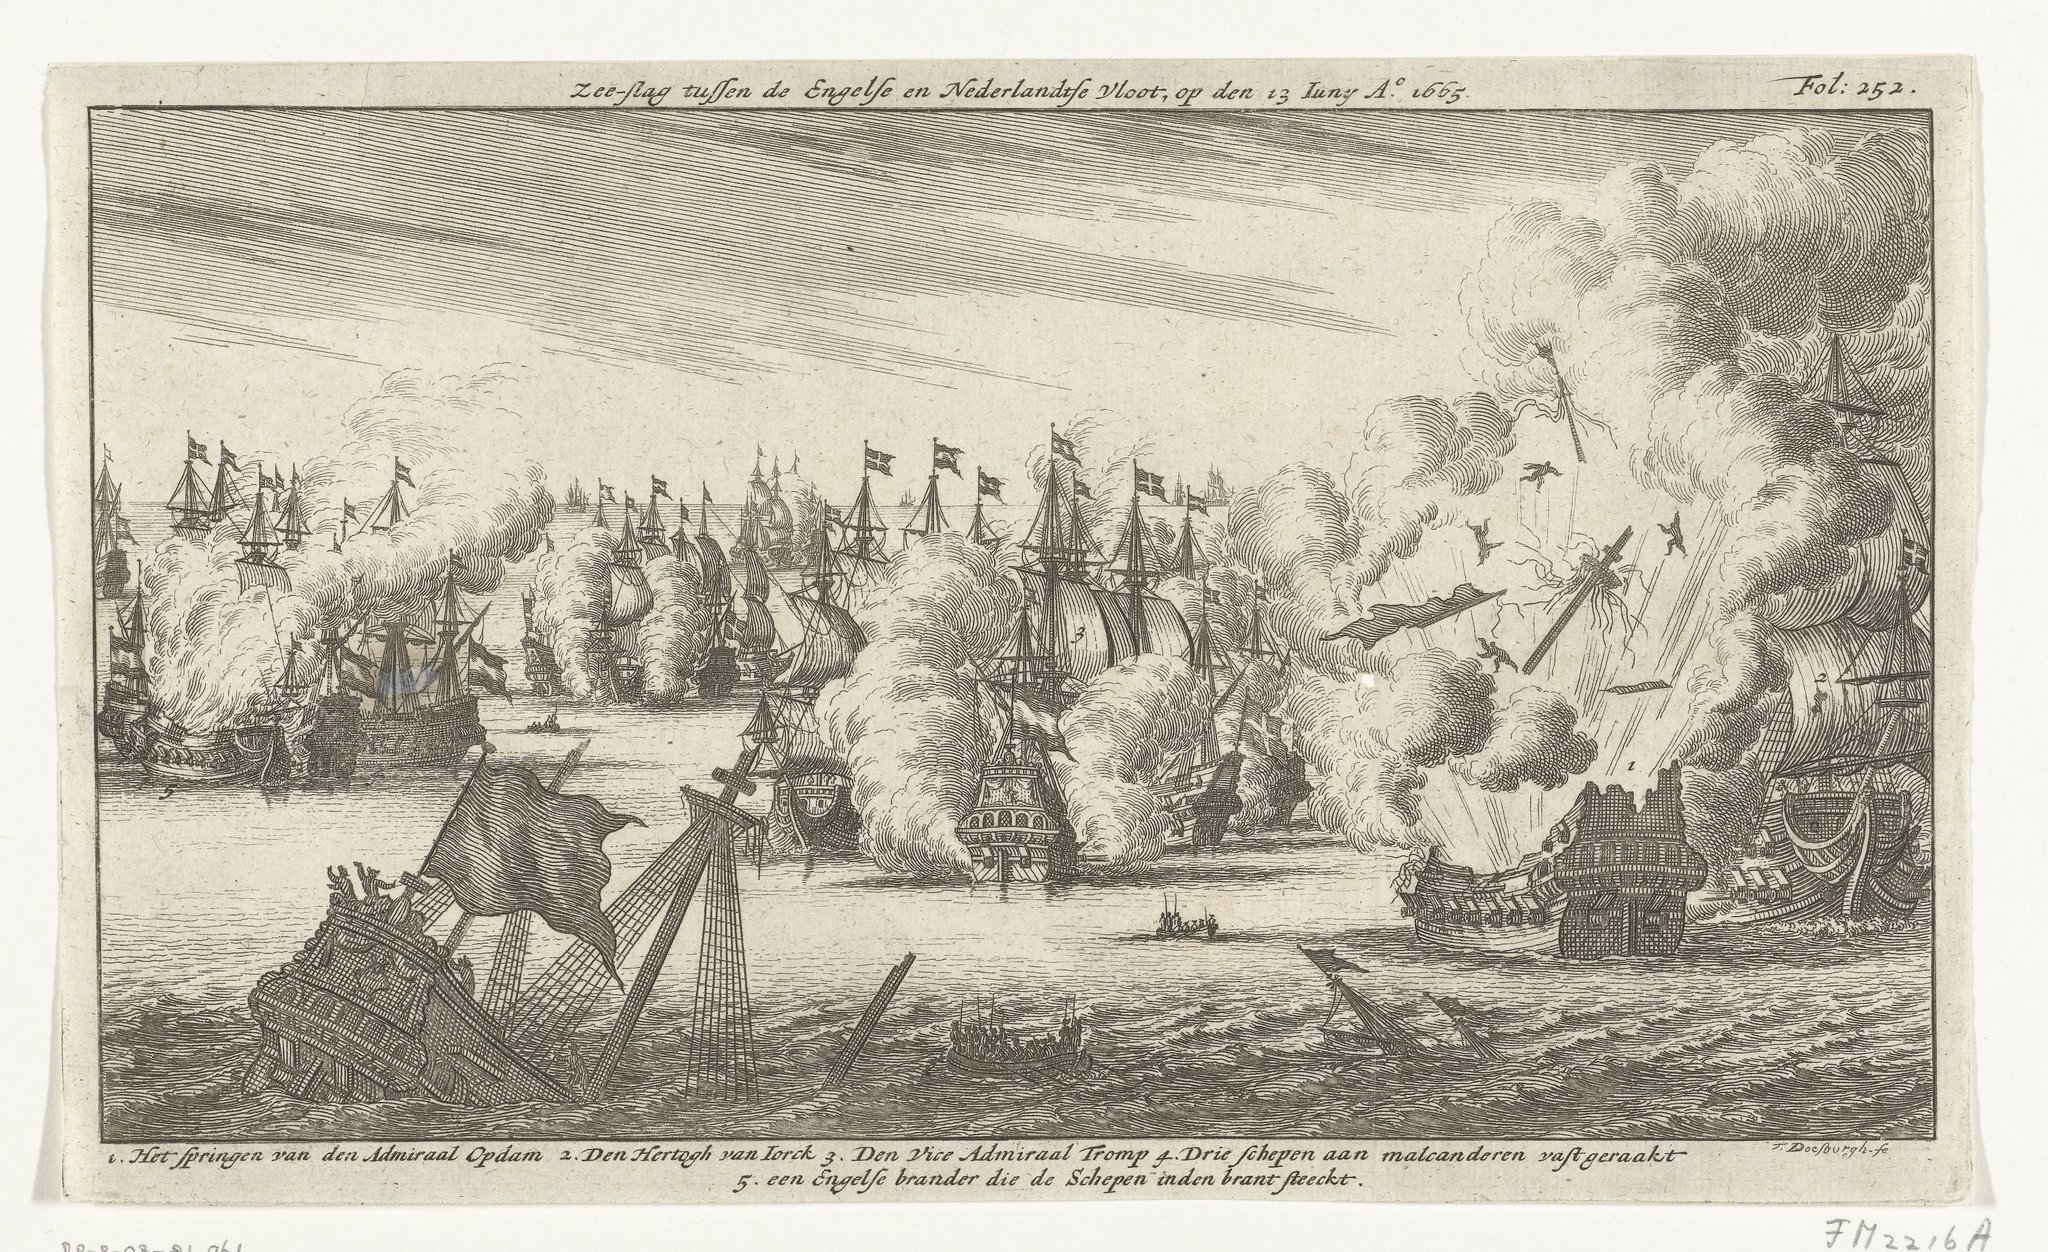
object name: history print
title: Zee-slag tussen de Engelse en Nederlandtse Vloot, op den 13 Juny Ao. 1665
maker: thomas doesburgh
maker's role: print maker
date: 1690-1692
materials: paper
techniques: etching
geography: northern netherlands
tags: james stuart (hertog van york), jacob baron van wassenaer heer van obdam, battle (+ naval force), battle of lowestoft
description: Zeegevecht voor Lowestoft (Lestoffe) tussen de Engelsen onder de hertog van York en de Nederlanders onder Wassenaer van Obdam, 13 juni 1665. Rechts het ontploffen van de Eendracht, het vlaggenschip van admiraal Wassenaer van Obdam.